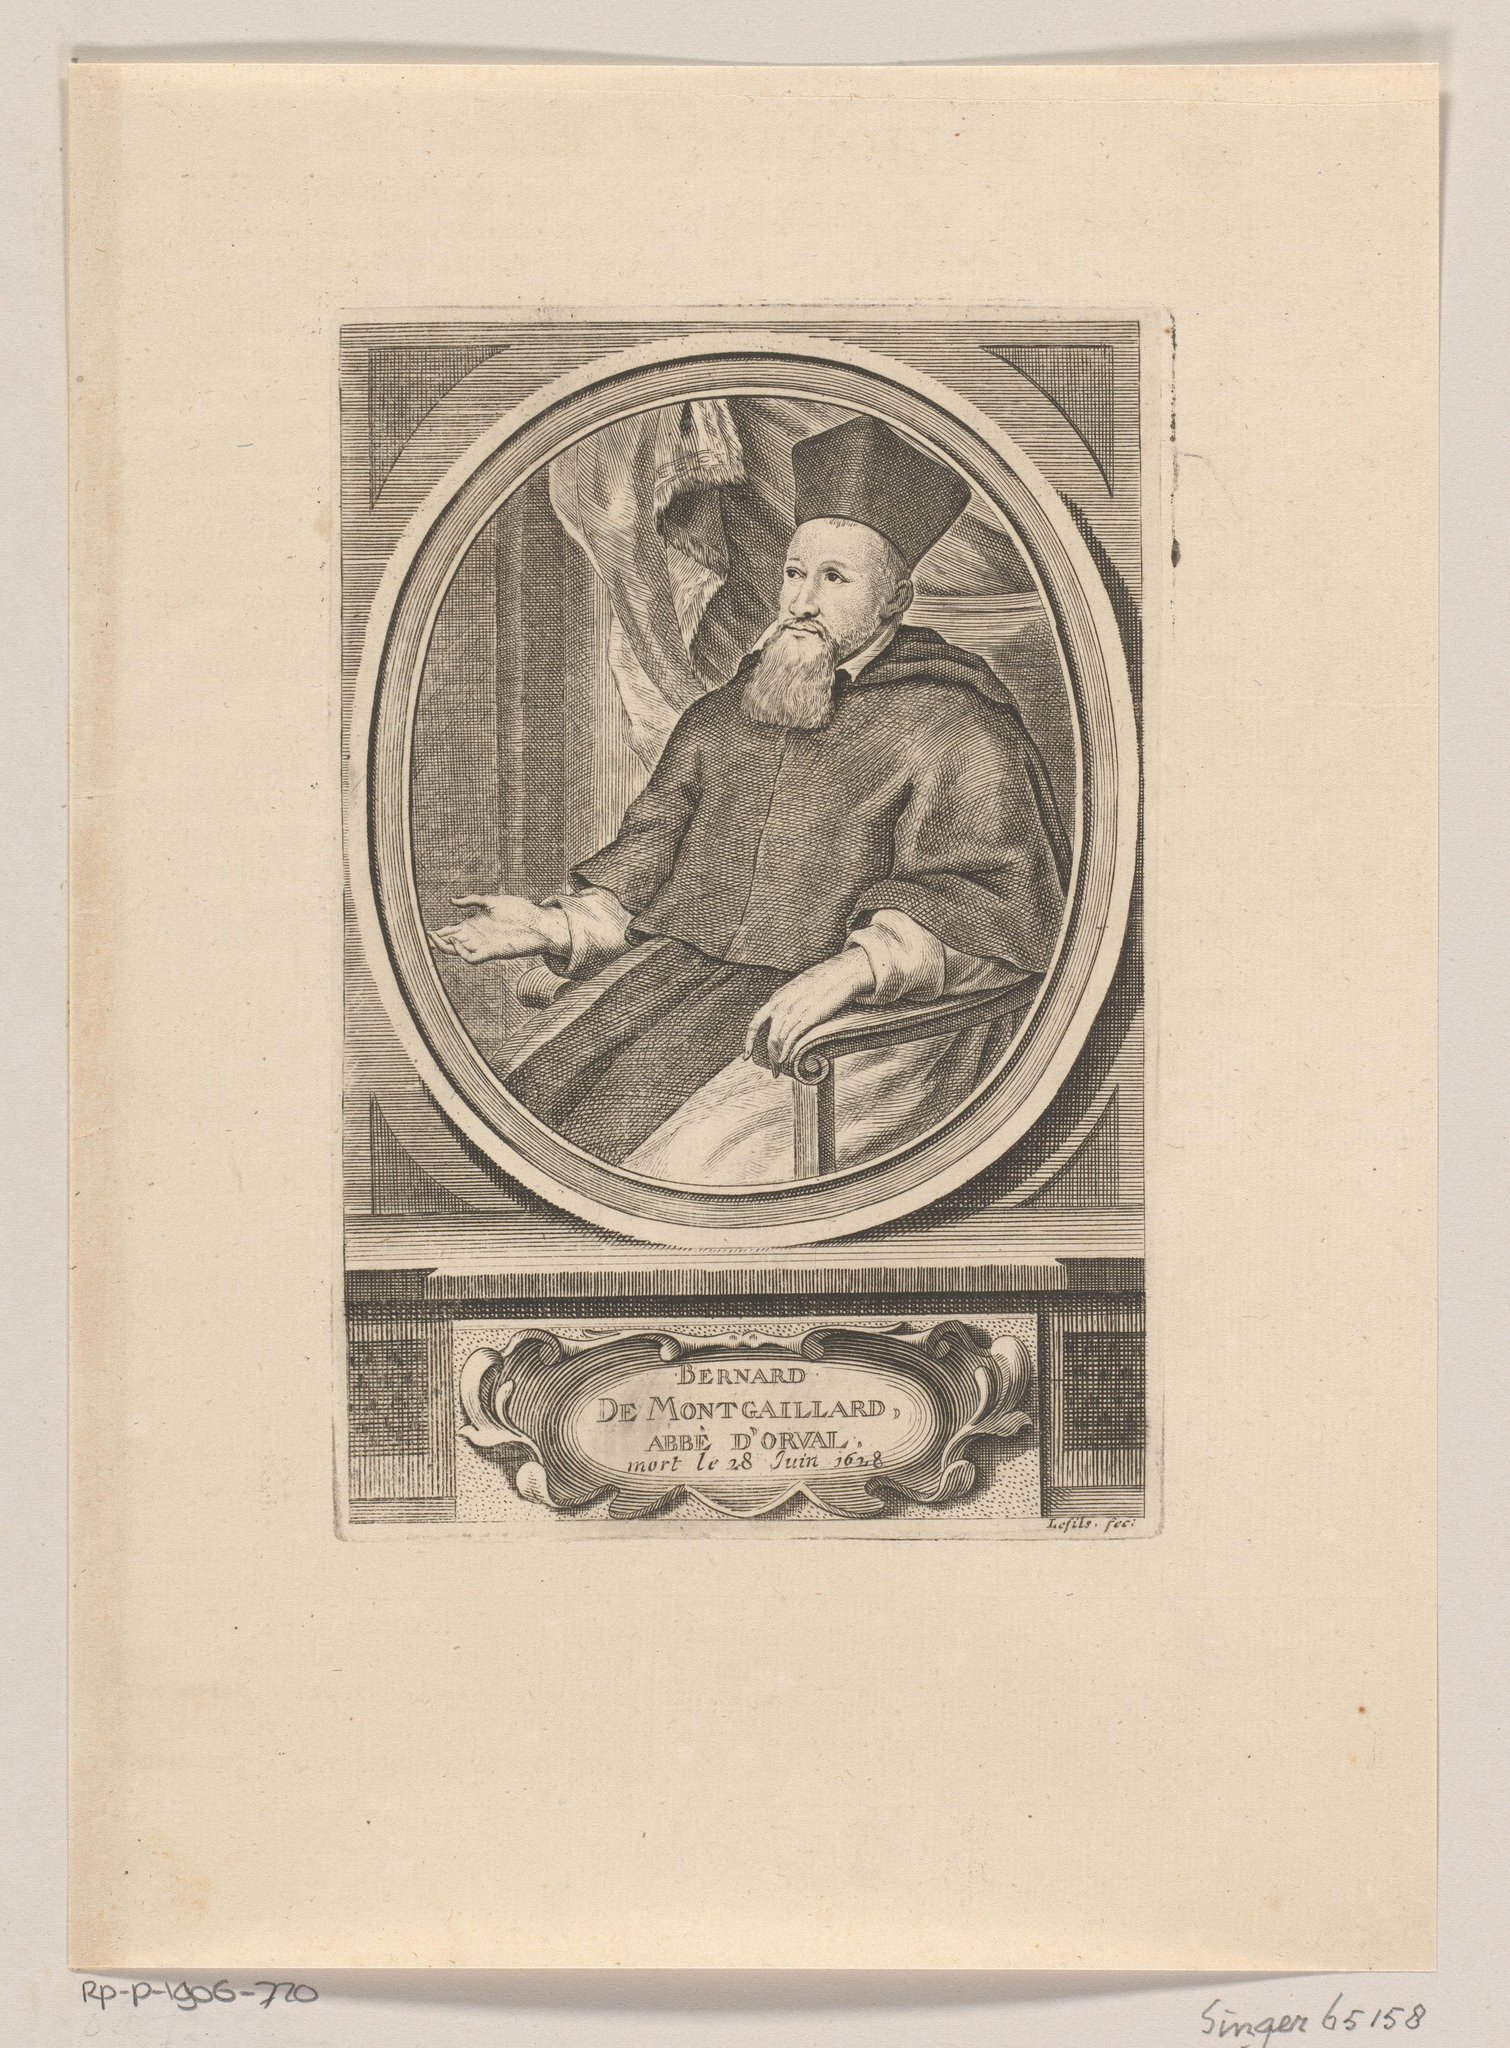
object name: print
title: Portret van Bernard de Montgaillard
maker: j.b. lefils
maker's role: print maker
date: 1628-1750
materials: paper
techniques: engraving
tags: priest, priest (roman catholic), historical persons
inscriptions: collector's mark: Lugt 2228